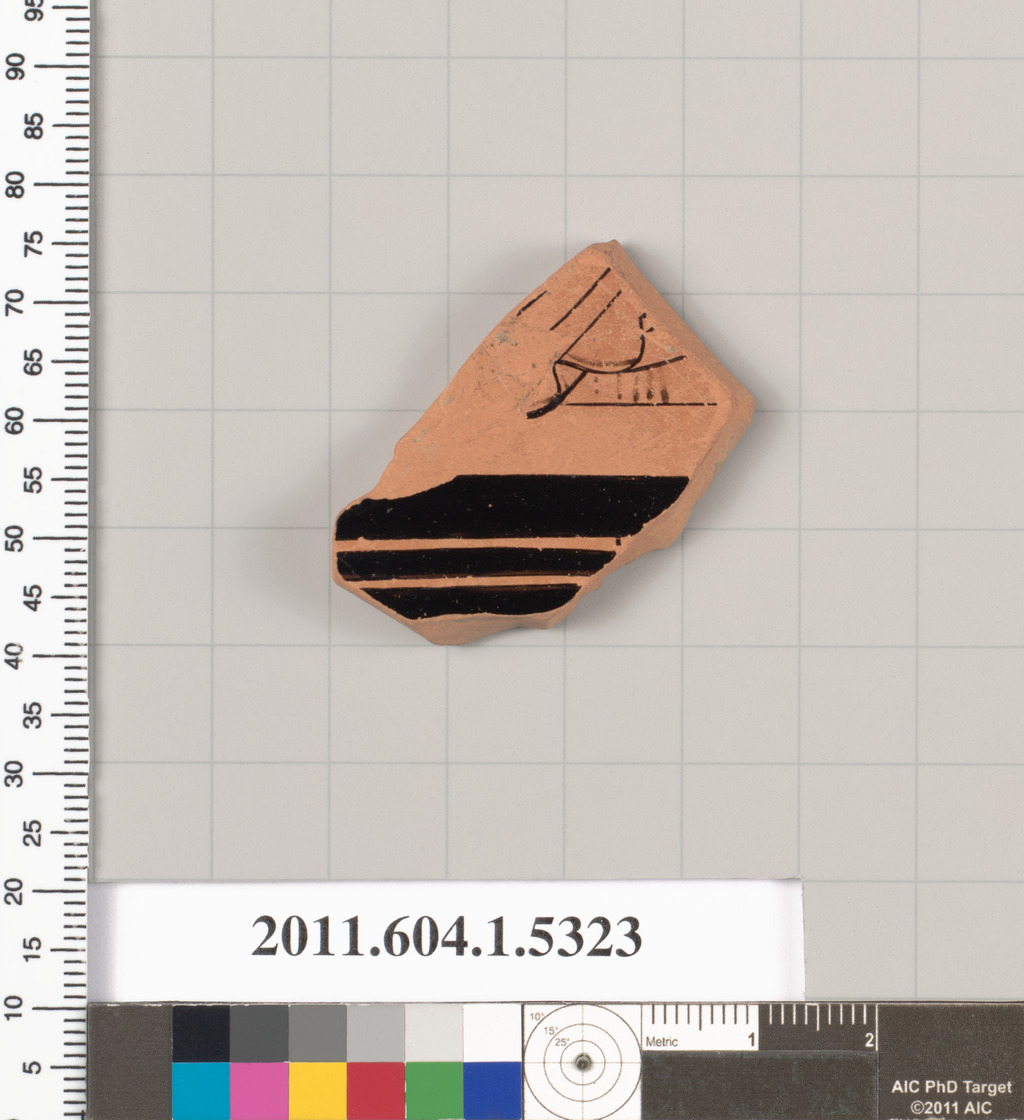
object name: kylix fragment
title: Terracotta fragment of a kylix (drinking cup)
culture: greek, attic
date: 500-480 BCE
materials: terracotta